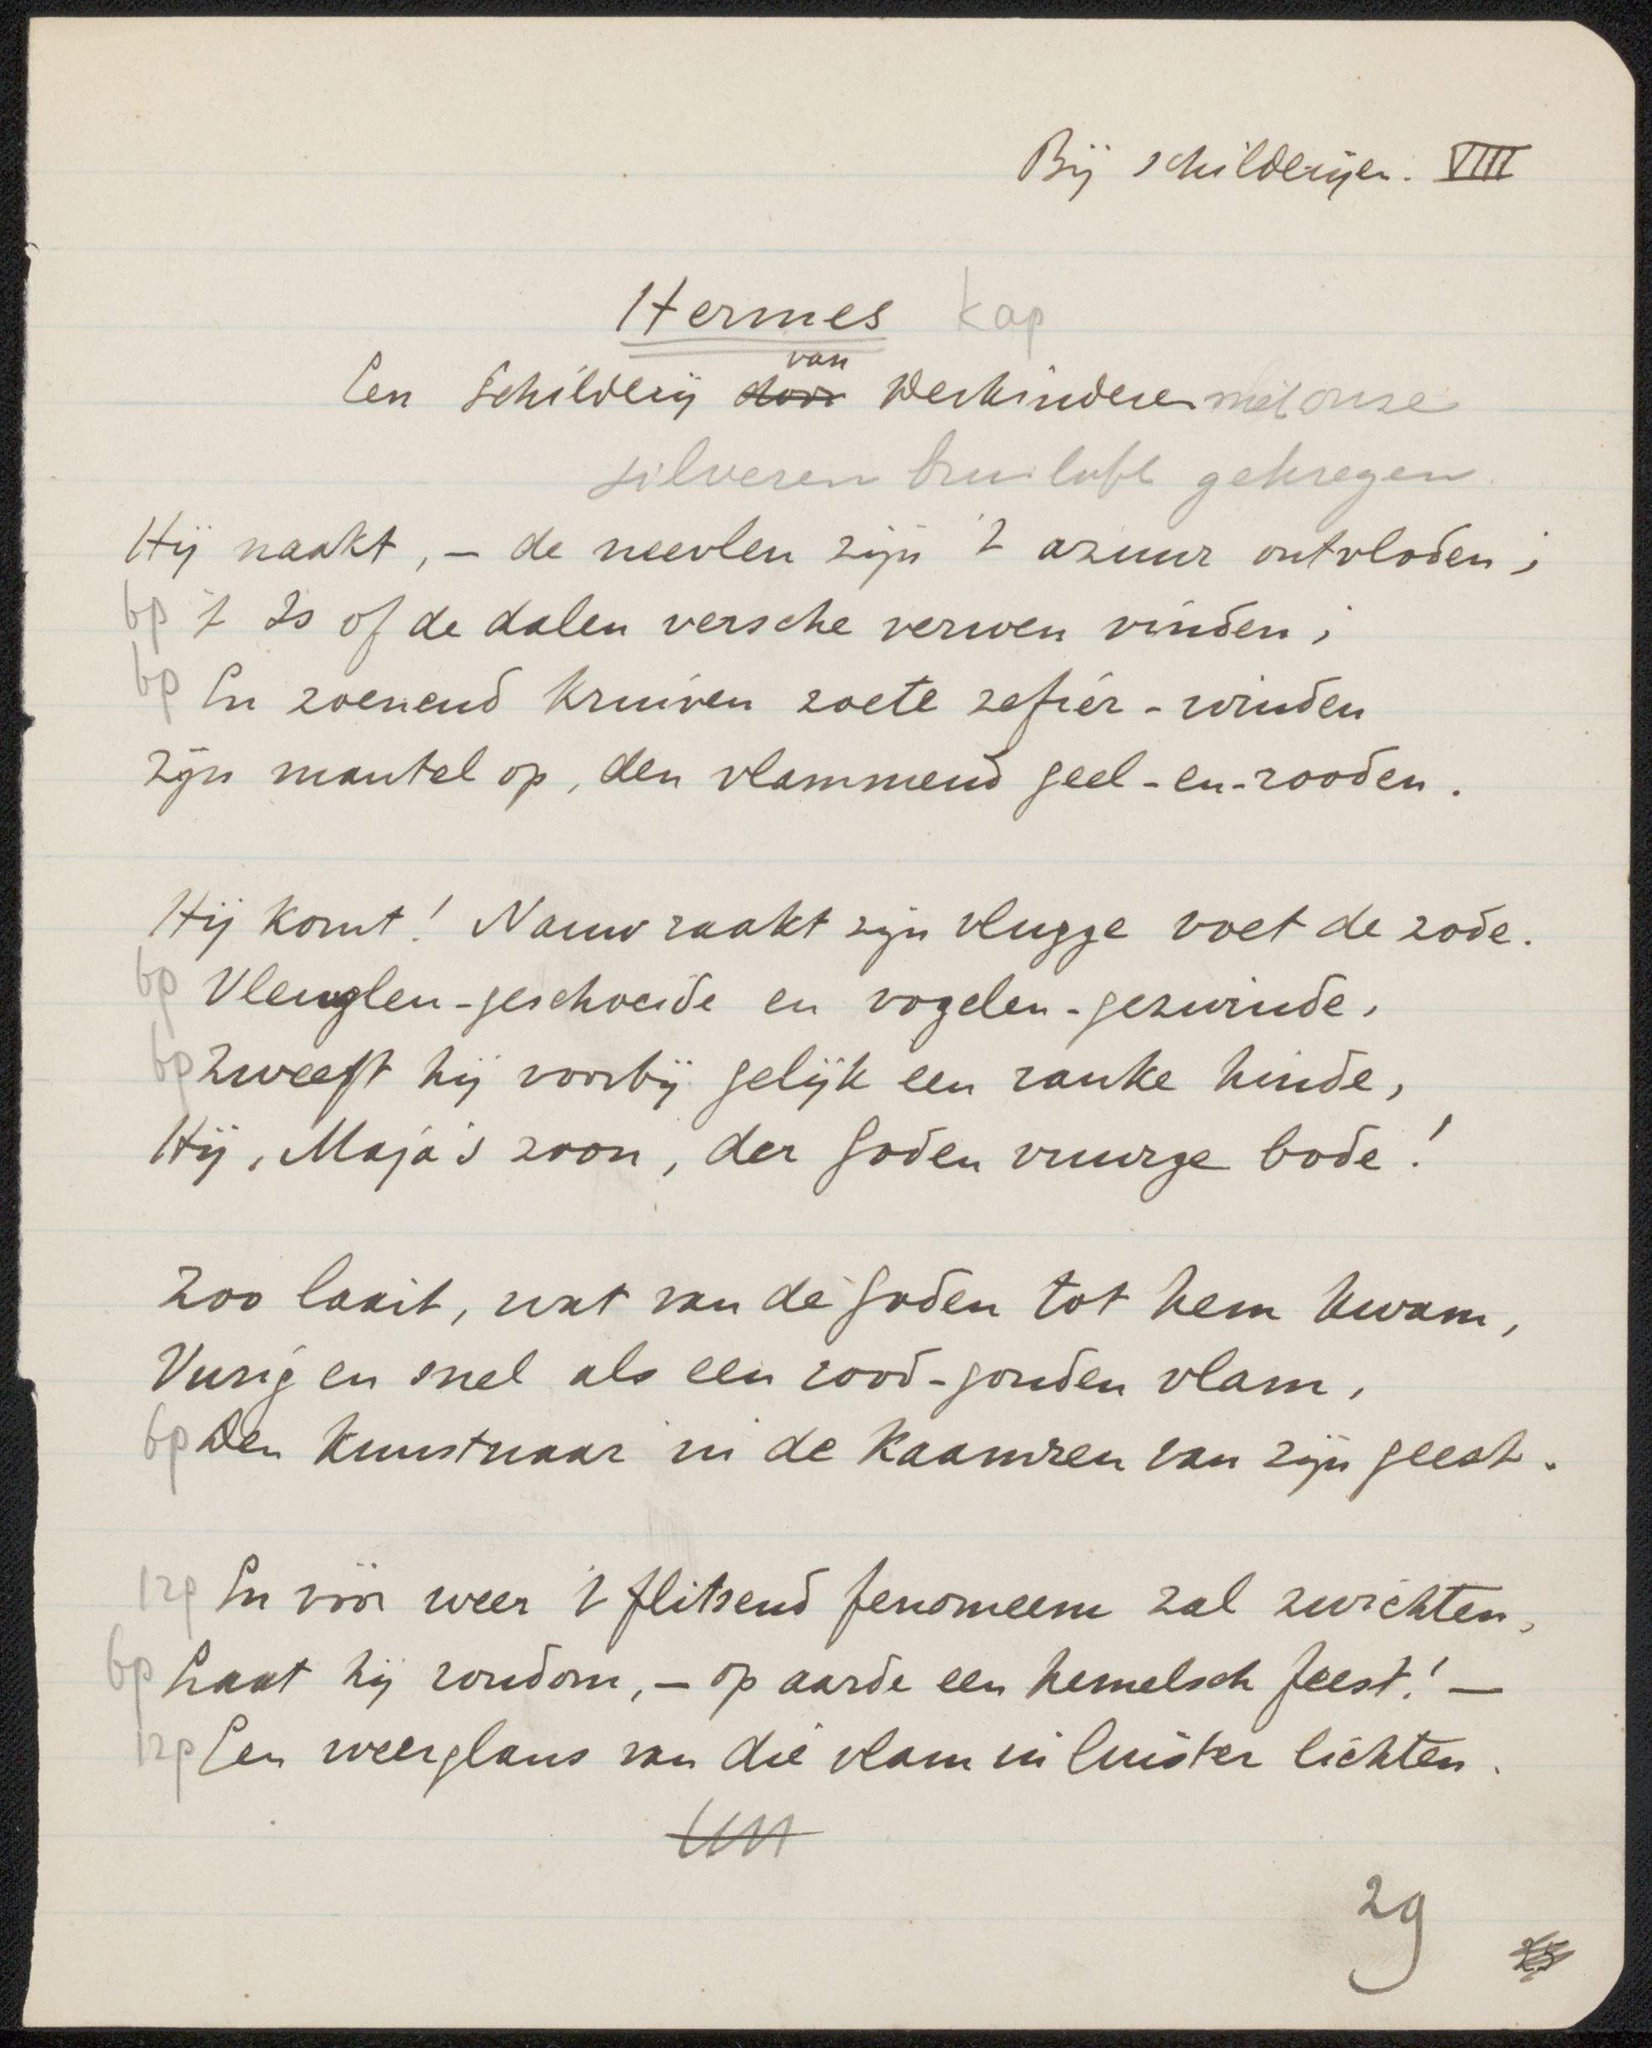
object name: poem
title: Gedicht uit archief Jan Veth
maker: jan veth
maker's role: designer, draughtsman, painter, print maker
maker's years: 1864-1925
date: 1874-1925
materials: ink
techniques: pen, writing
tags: den bosch, antoon derkinderen, painting (including book-illumination, miniature-painting)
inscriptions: collector's mark: ‘RPK’